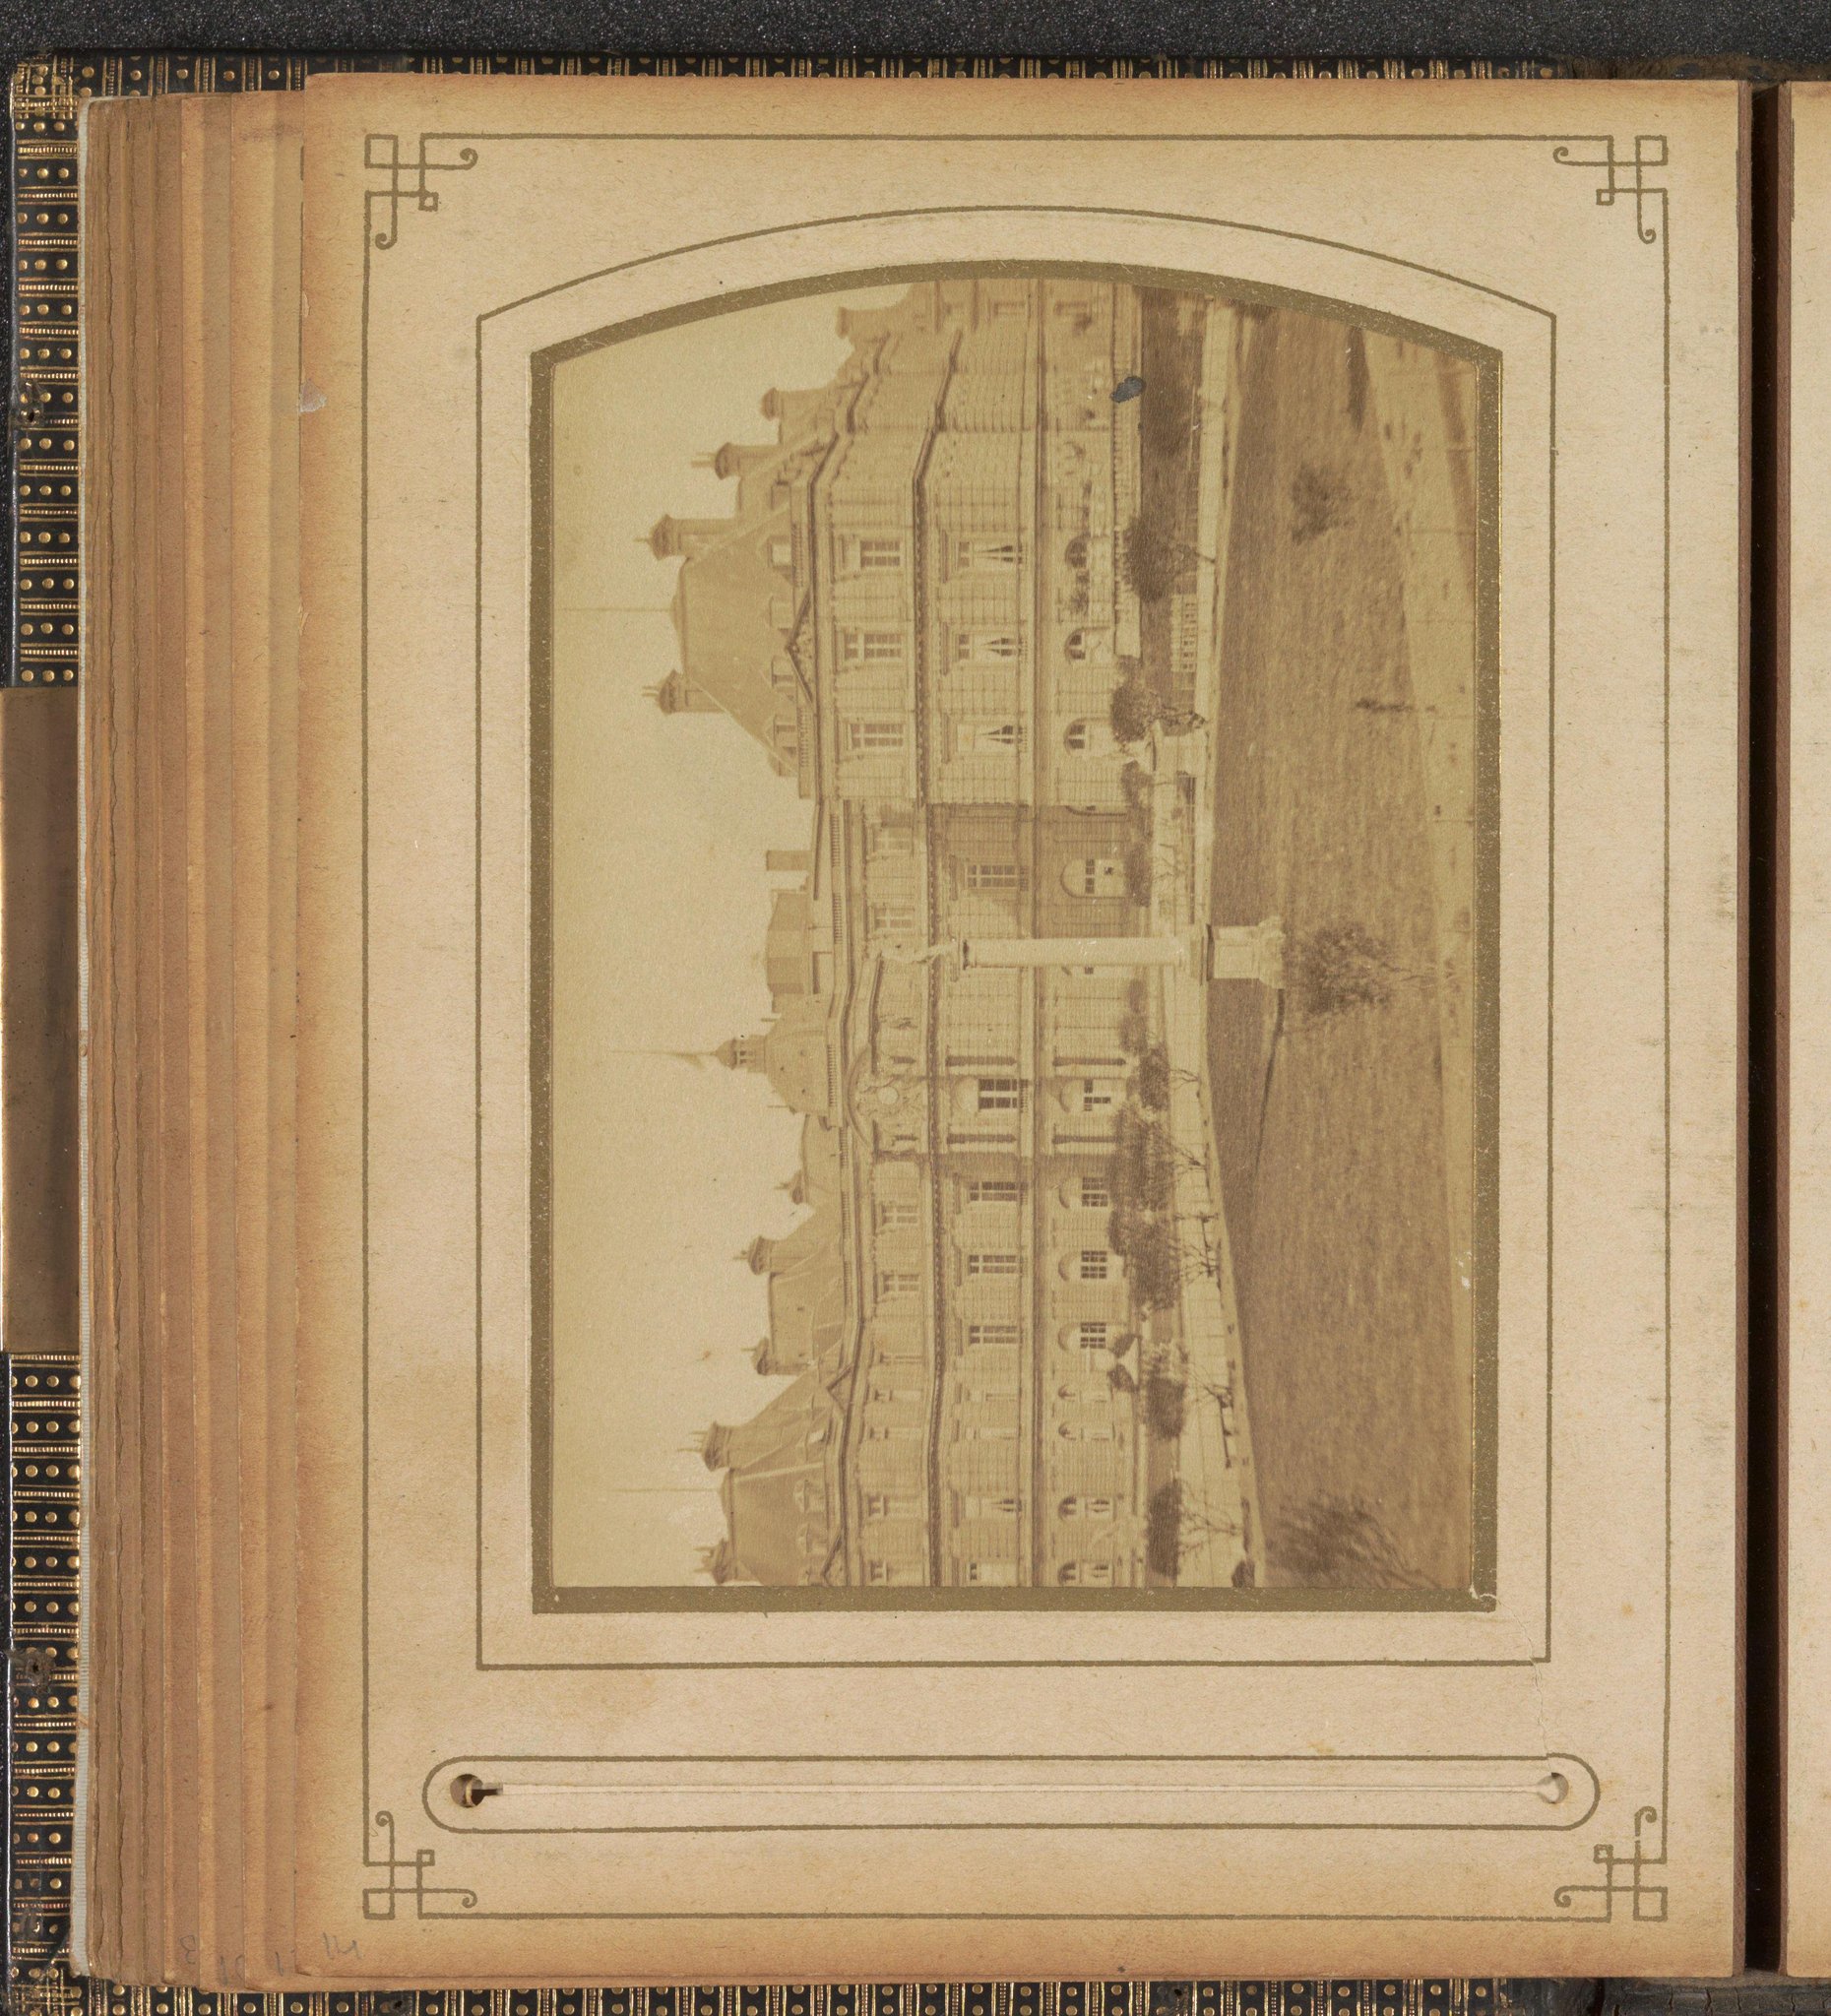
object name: photograph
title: Palais du Luxembourg a Paris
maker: Anonymous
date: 1870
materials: cardboard, paper, photographic support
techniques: albumen print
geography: paris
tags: palace, piece of sculpture, reproduction of a piece of sculpture, courtyard, paris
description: Onderdeel van Fotoalbum met kabinetfoto's van bezienswaardigheden in Parijs.